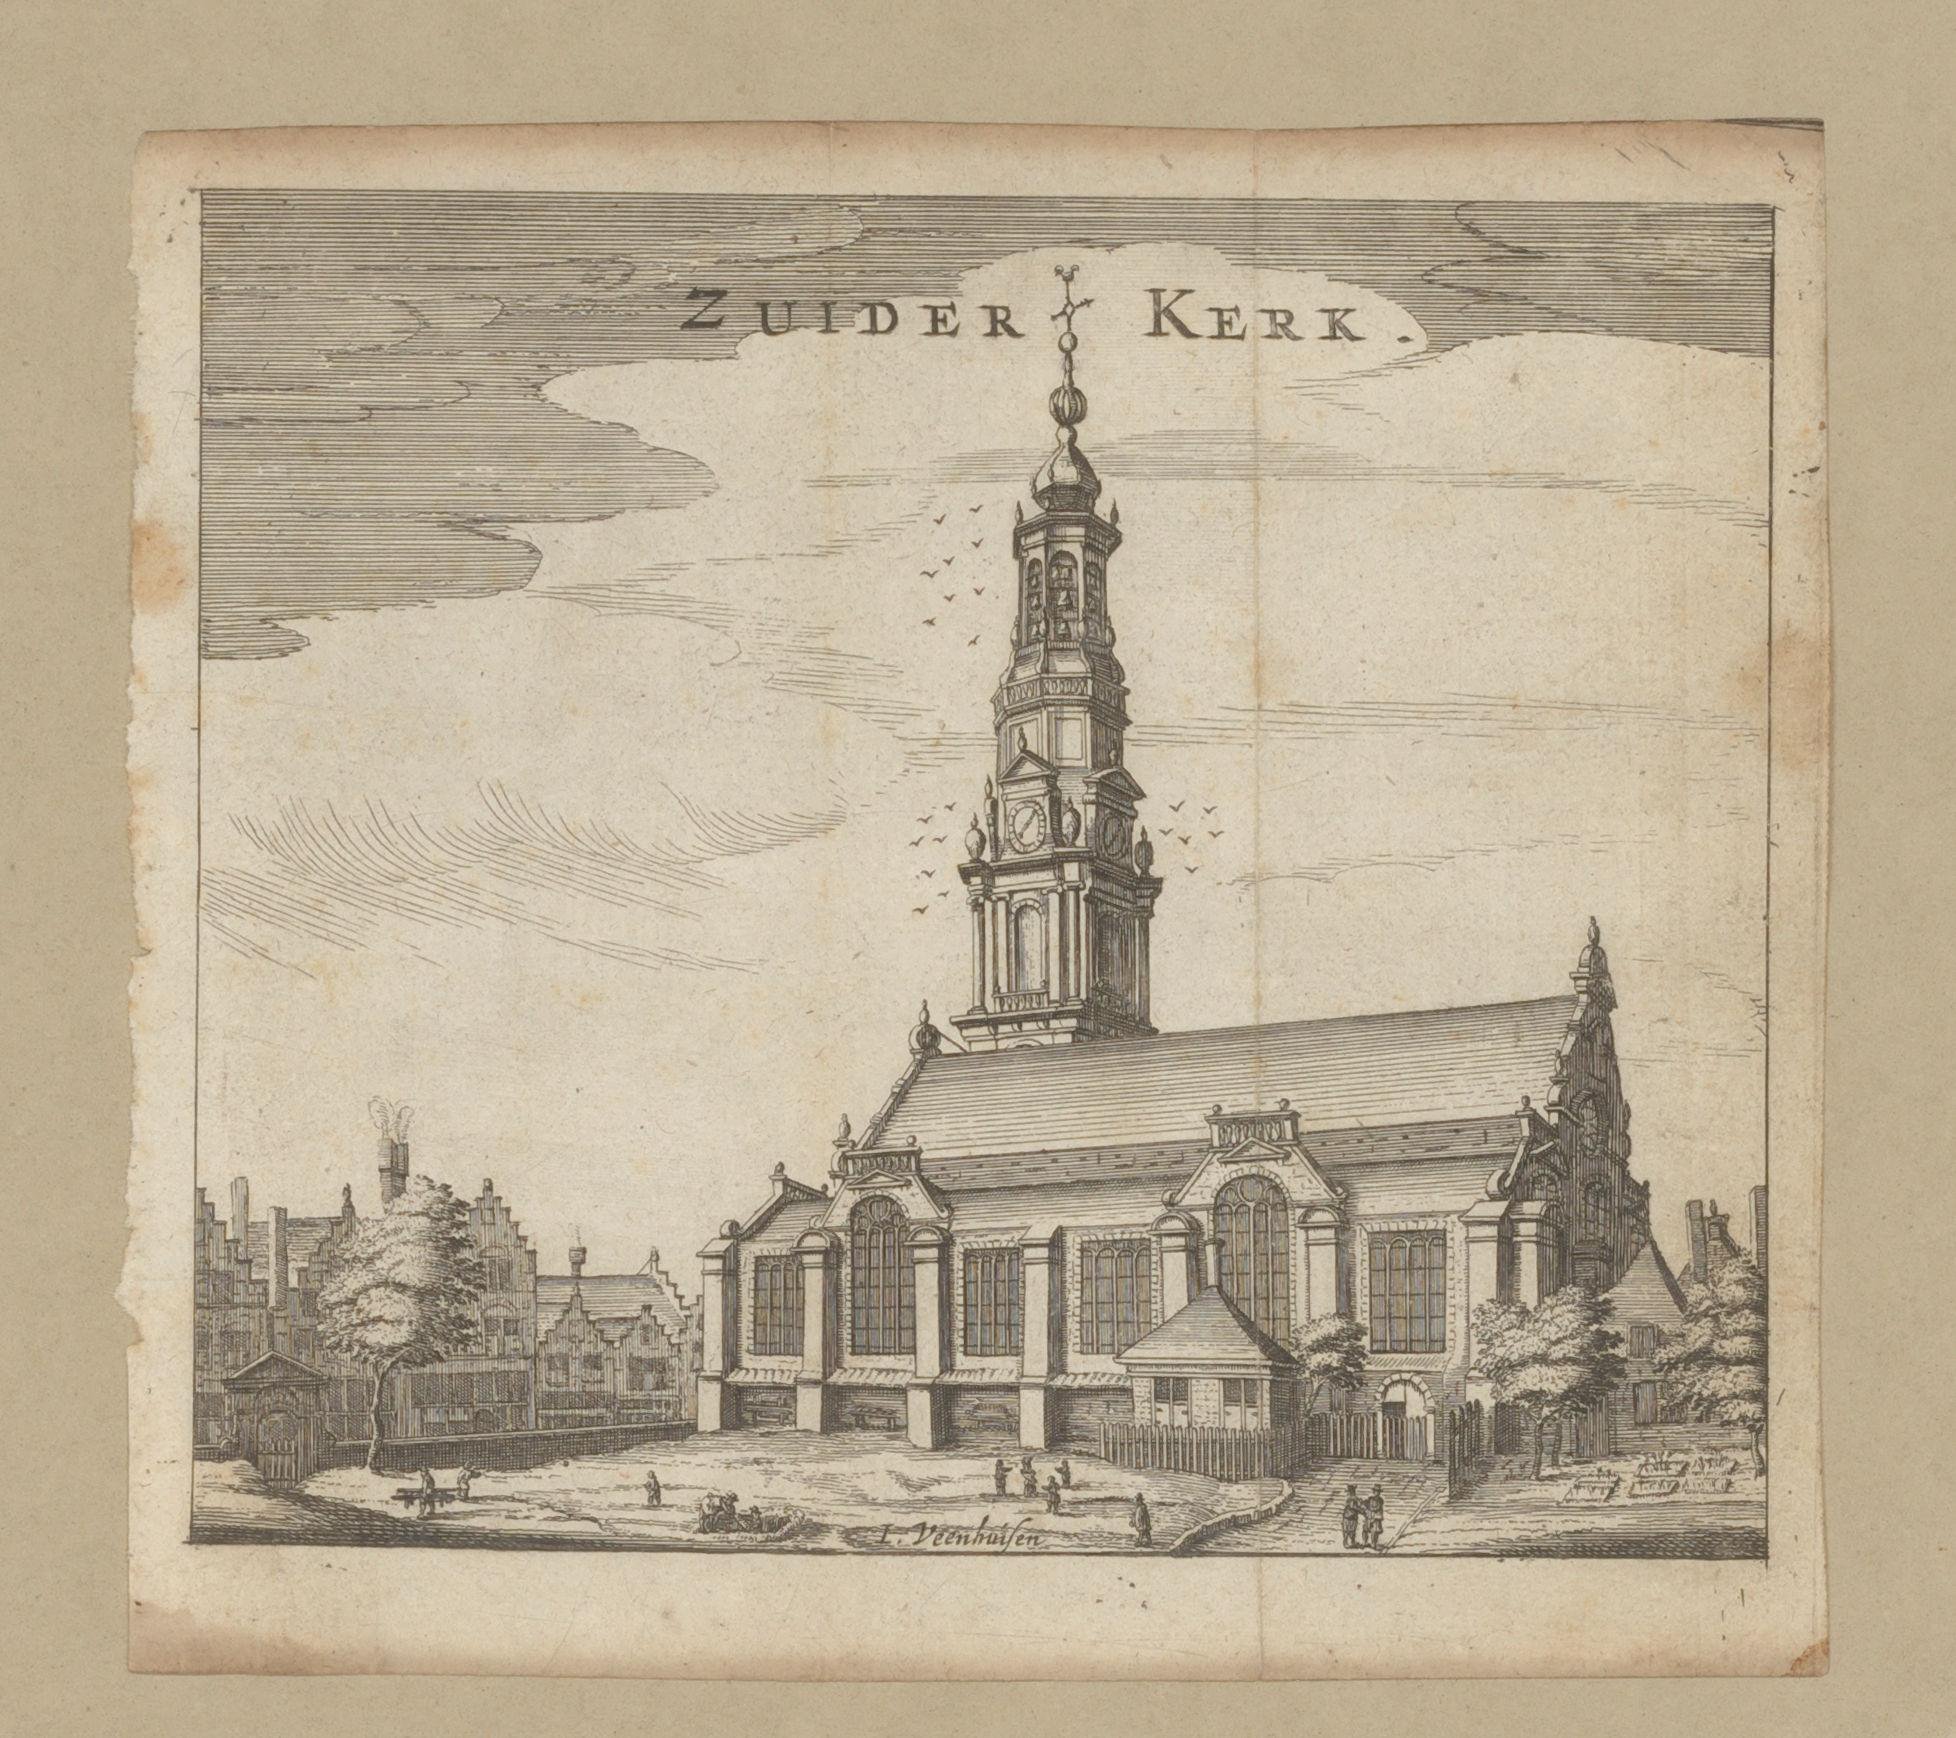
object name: print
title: Gezicht op de Zuiderkerk te Amsterdam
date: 1664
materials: paper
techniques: engraving, etching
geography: amsterdam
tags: church (exterior), churchyard, cemetery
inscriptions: collector's mark: Lugt 1641b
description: Huidige staat van prent ook gebruikt in: Fockens, Melchior. Beschrijvingh Der wijdt-vermaarde Koop-stadt Amstelredam (…). 3de druk. Amsterdam: Marcus Willemsz. Doornick, 1664. En in: Zesen, Philipp von. Beschreibung der Stadt Amsterdam (…). Amsterdam: Marcus Wilhelm Doornick, 1664. Eerste bekende staat (rechtsboven genummerd: 225) ook gebruikt in: Fockens, Melchior. Beschrijvinge Der wijdt-vermaarde Koop-stadt Amstelredam (…). 2de druk. Amsterdam: Marcus Willemsz. Doornick, 1662. Derde bekende staat (met toevoeging Franse titel) ook gebruikt in: Domselaer, Tobias en Isaac Commelin. Beschryvinge van Amsterdam (…). 6 dln. Amsterdam: Marcus Willemsz. Doornick, 1665, dl. 4, p. 78. Vierde bekende staat (rechtsboven genummerd: 12) ook gebruikt in verschillende latere zeventiende- en achttiende-eeuwse publicaties.